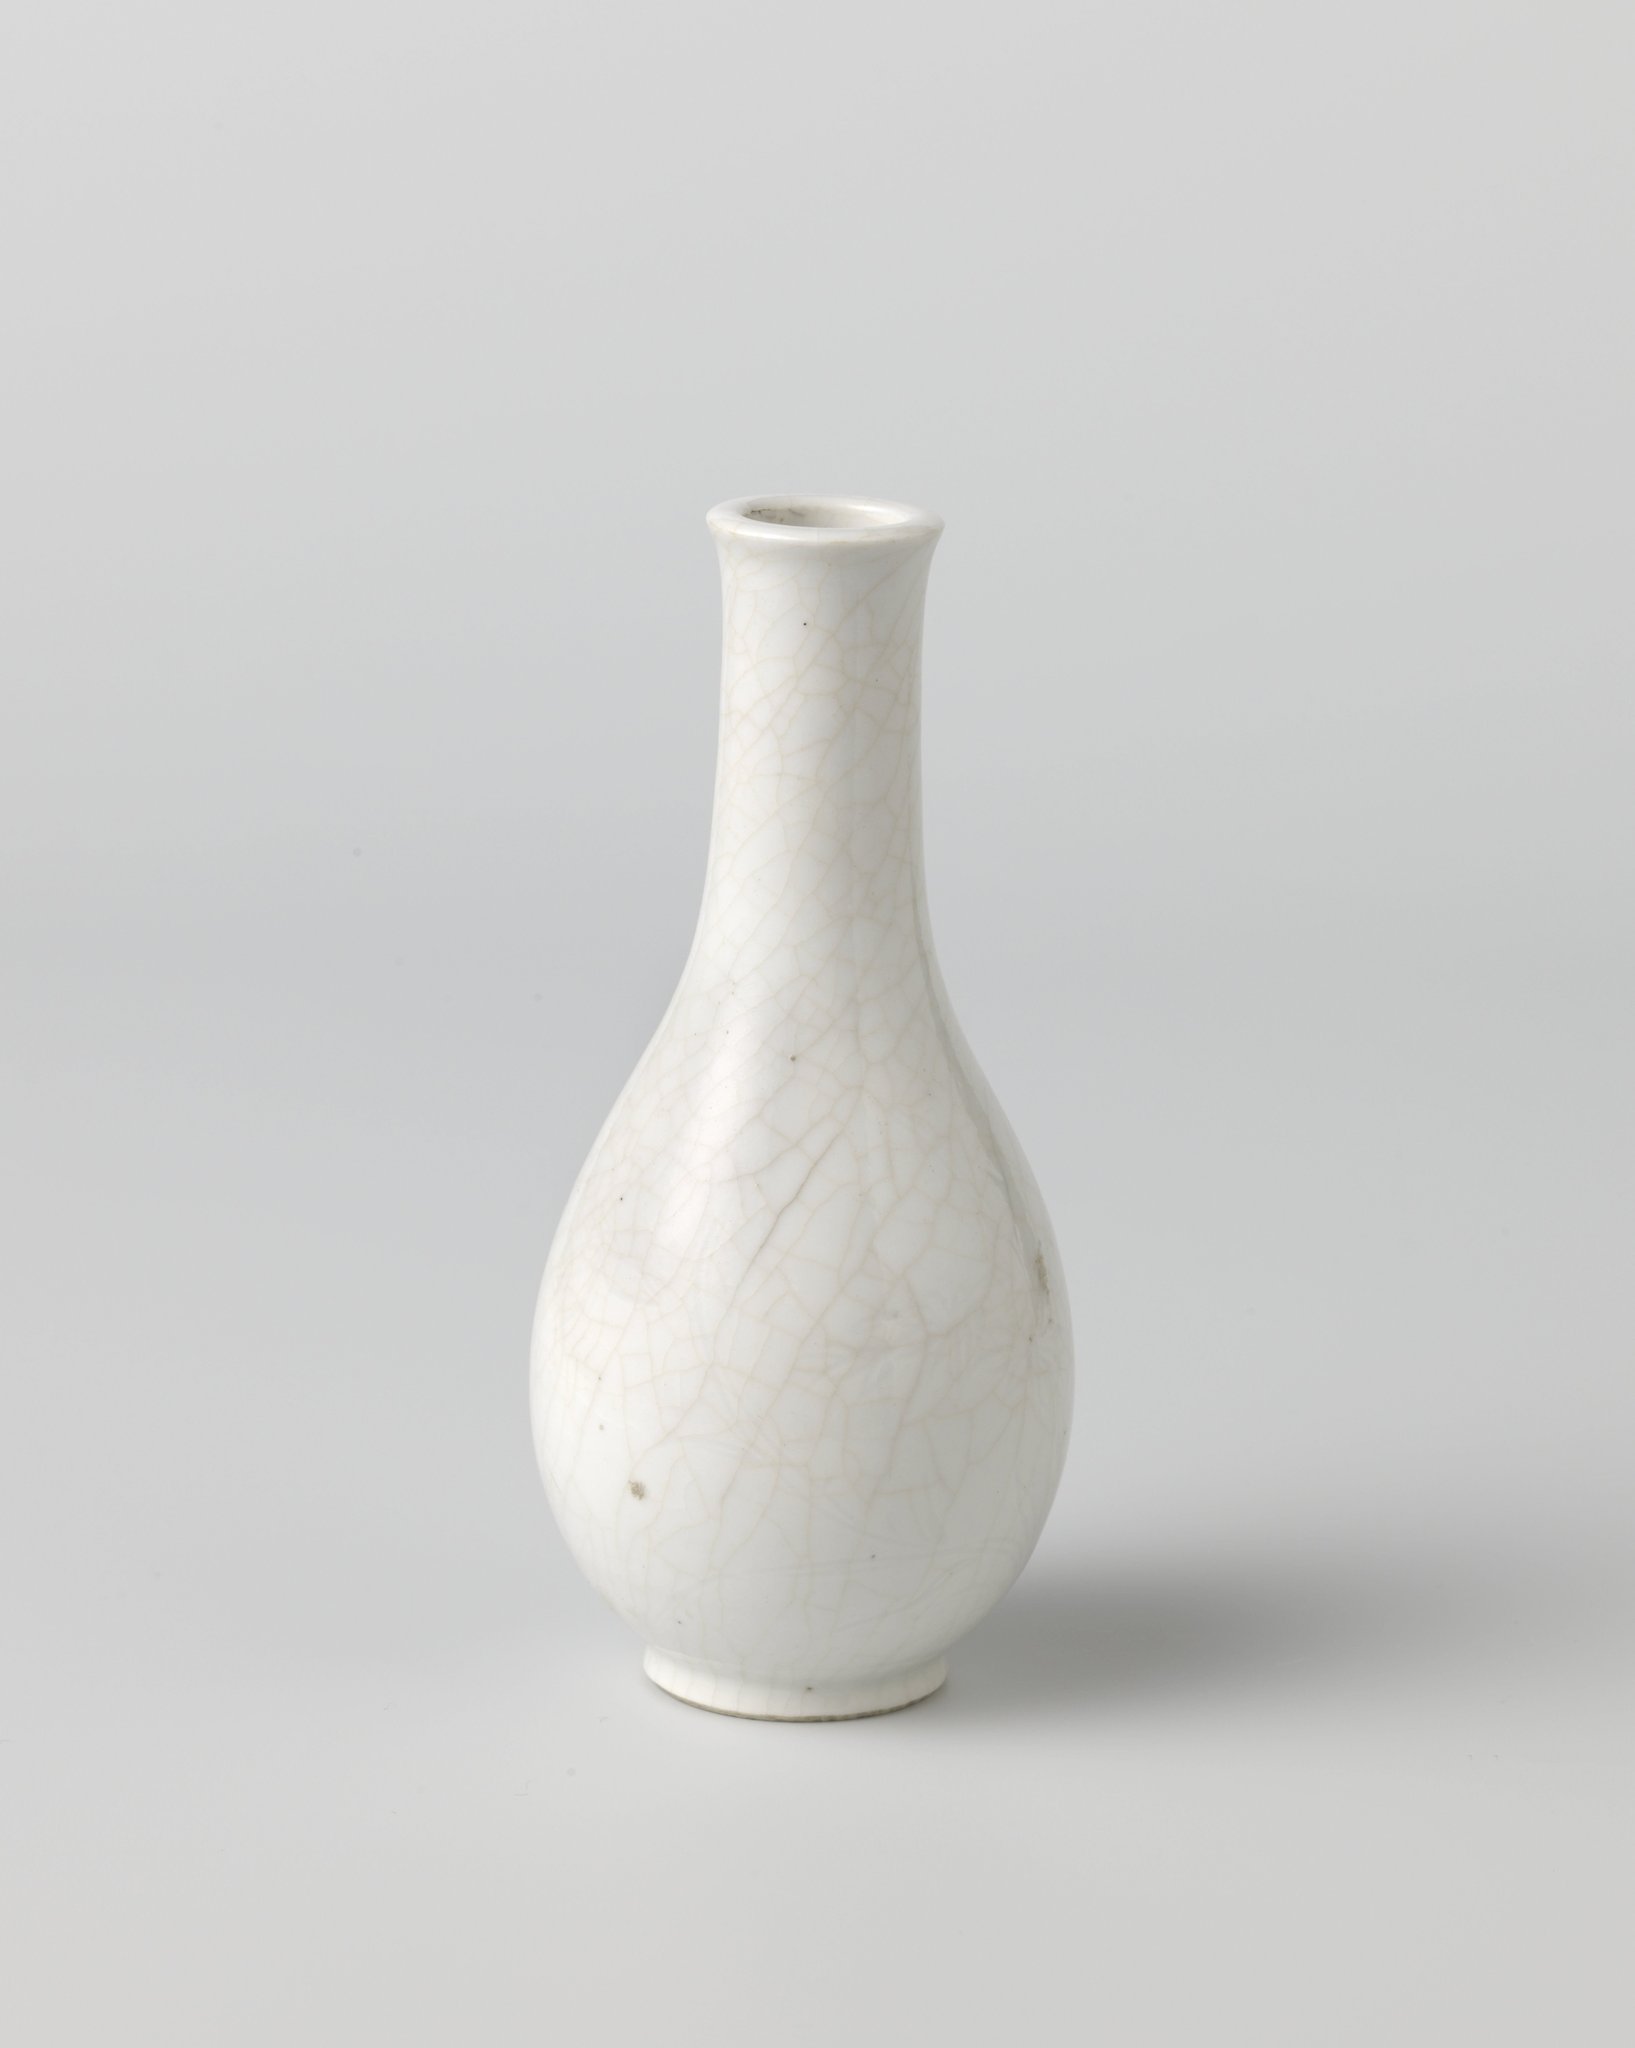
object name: vase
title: Pear-shaped vase with incised flowering plants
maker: Anonymous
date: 1700-1799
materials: glaze, porcelain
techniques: engraving, firing, turning, vitrification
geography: china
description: Peervormige vaas van porselein, bedekt met een doorschijnend wit, gecraqueleerd glazuur. De wand is versierd met ingegrifte bloeiende planten. Wit porselein, monochromen.